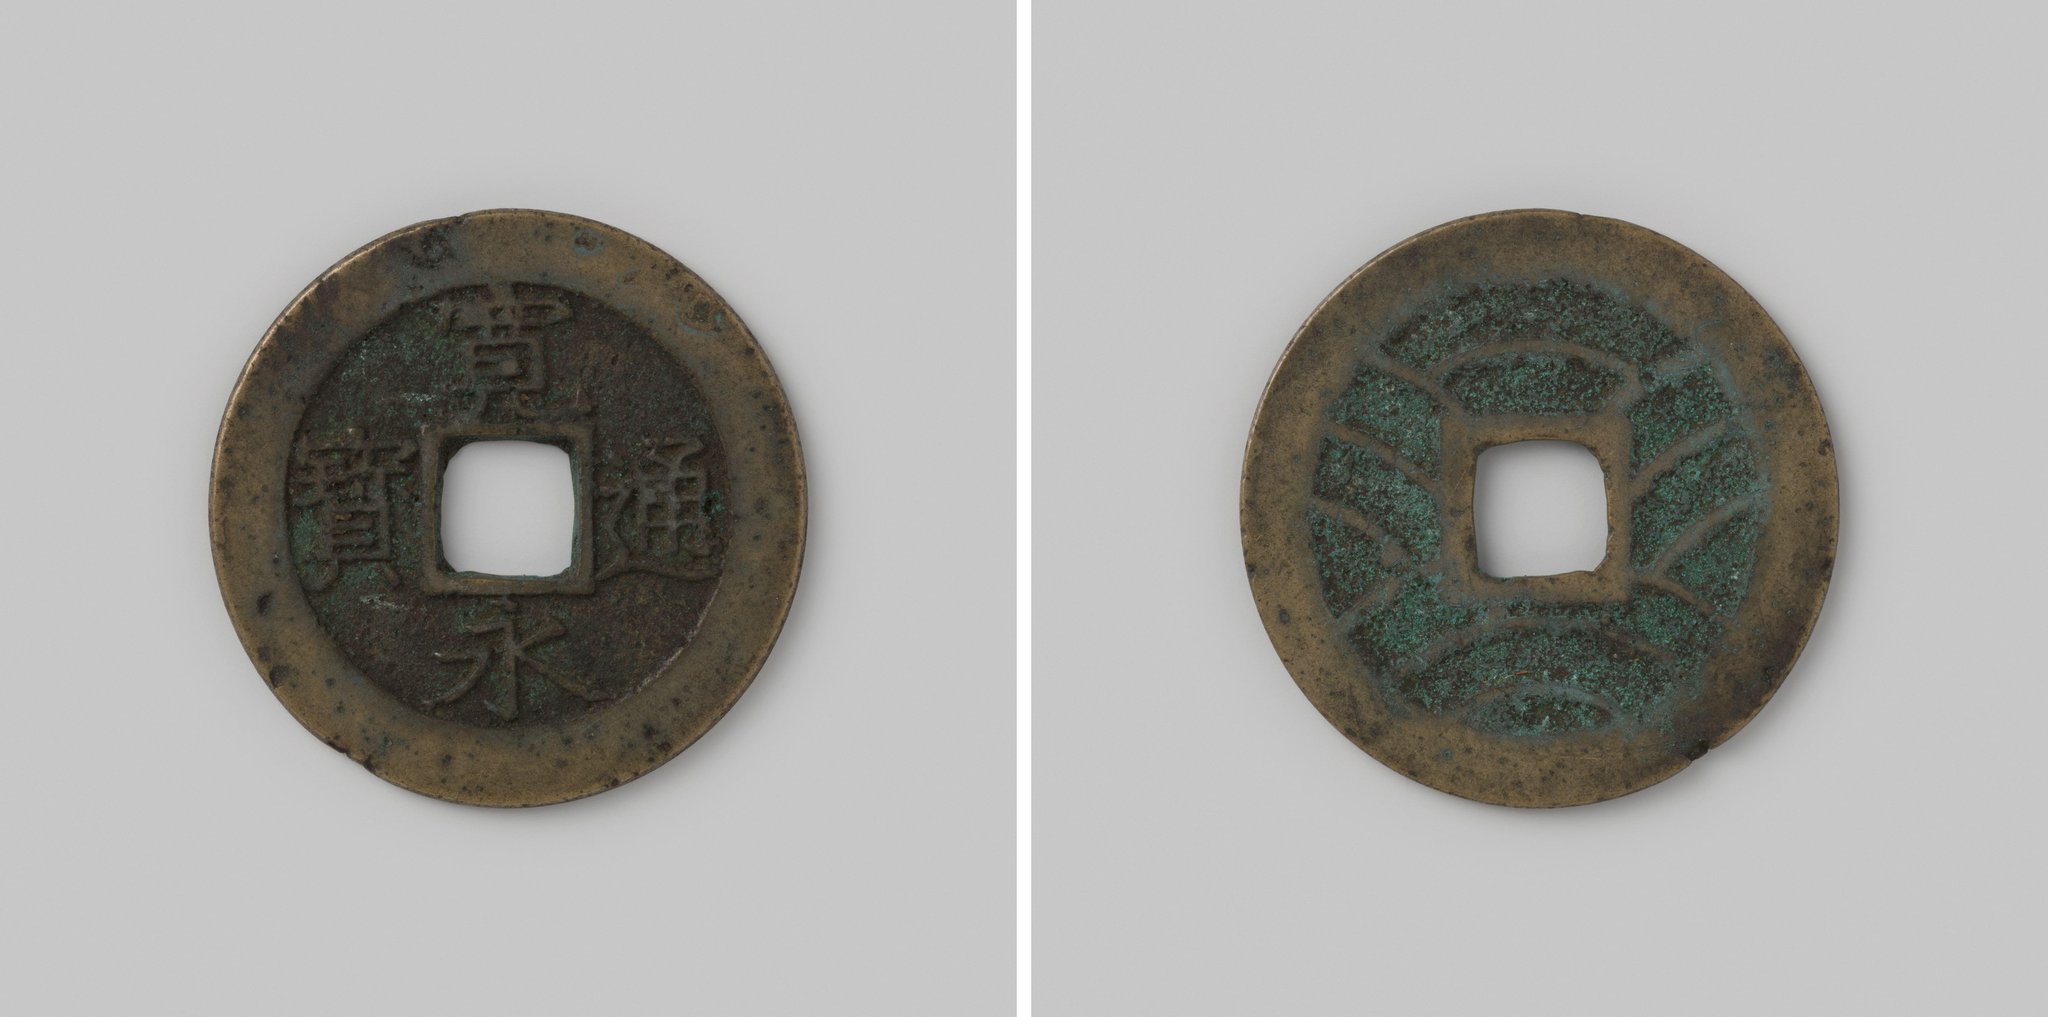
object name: sen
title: Keizerrijk Japan, sen van 4 mon, uit het Meiwa tijdperk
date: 1764-1771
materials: copper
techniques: casting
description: Koperen munt. Voorzijde: binnen brede gladde rand rondom vierkante uitsparing in het midden vier kruisgewijze geplaatste tekens met de betekenis: kanei tsuho [= kanei periode]. Keerzijde: binnen brede gladde rand elf gebogen strepen, golven